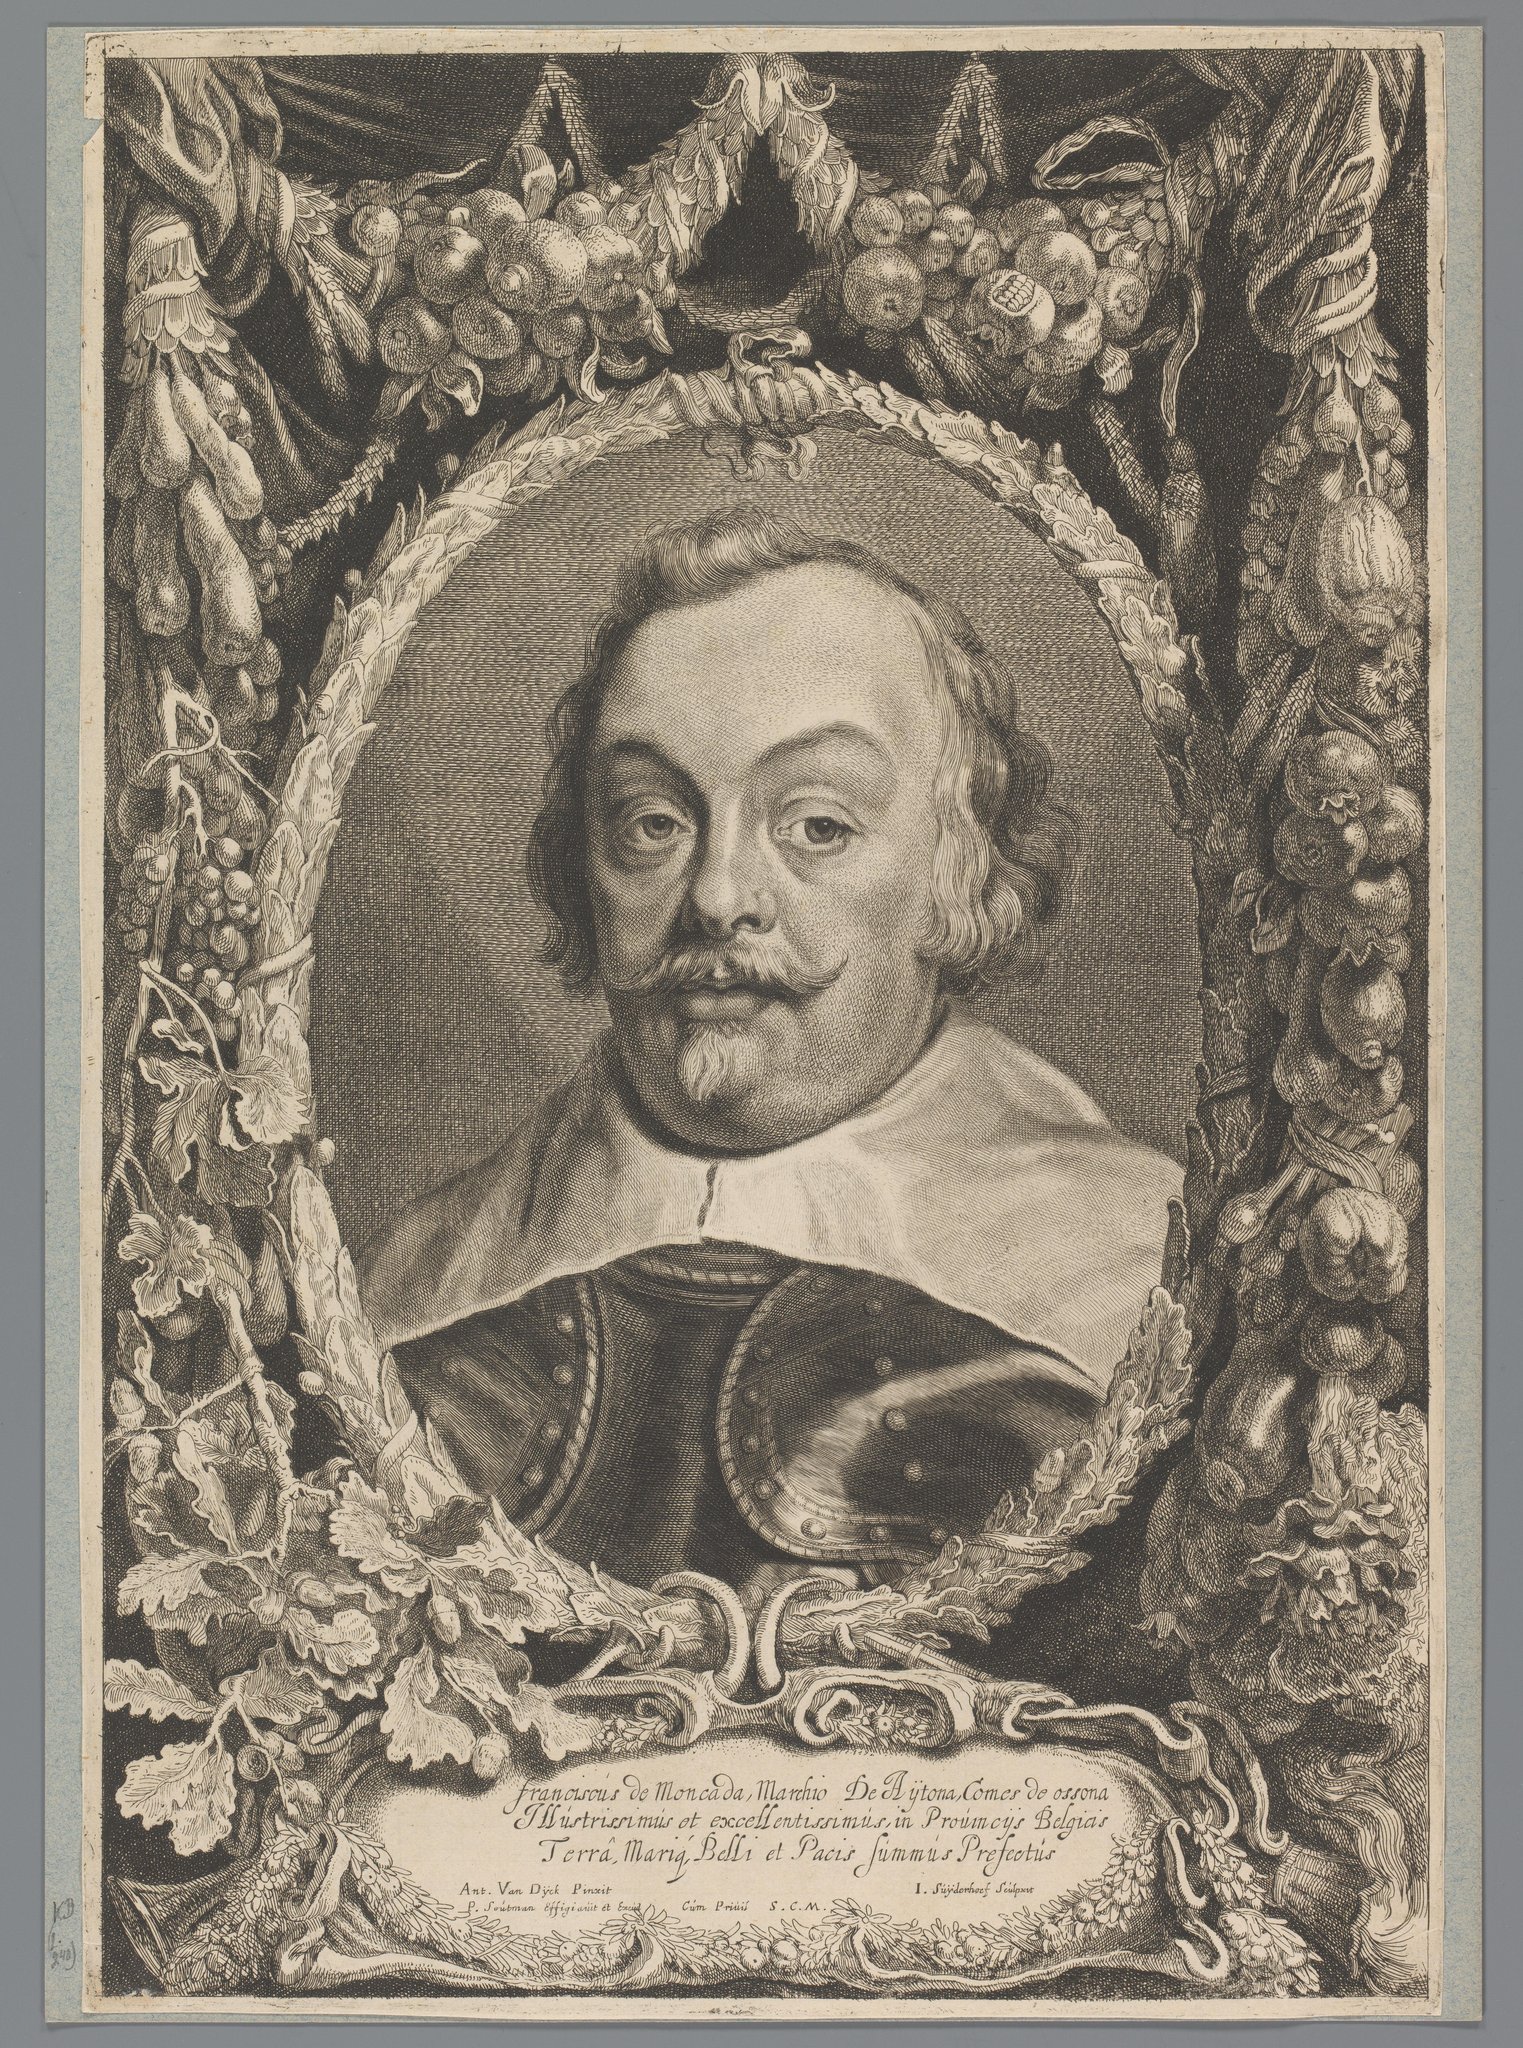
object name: print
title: Ferdinandus II[us] et III[us] Imperatorum Domus Austriacae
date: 1644-1650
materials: paper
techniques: engraving, etching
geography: haarlem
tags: brussels, francisco de moncada (markies van aytona), historical persons, ornament ~ festoon, garland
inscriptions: collector's mark: Lugt 3937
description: De prenten in de serie 'Ferdinandus II[us] et III[us] Imperatorum Domus Austriacae' zijn vervaardigd door verschillende graveurs: Jonas Suyderhoef, Jacob Louys en Pieter van Sompel.